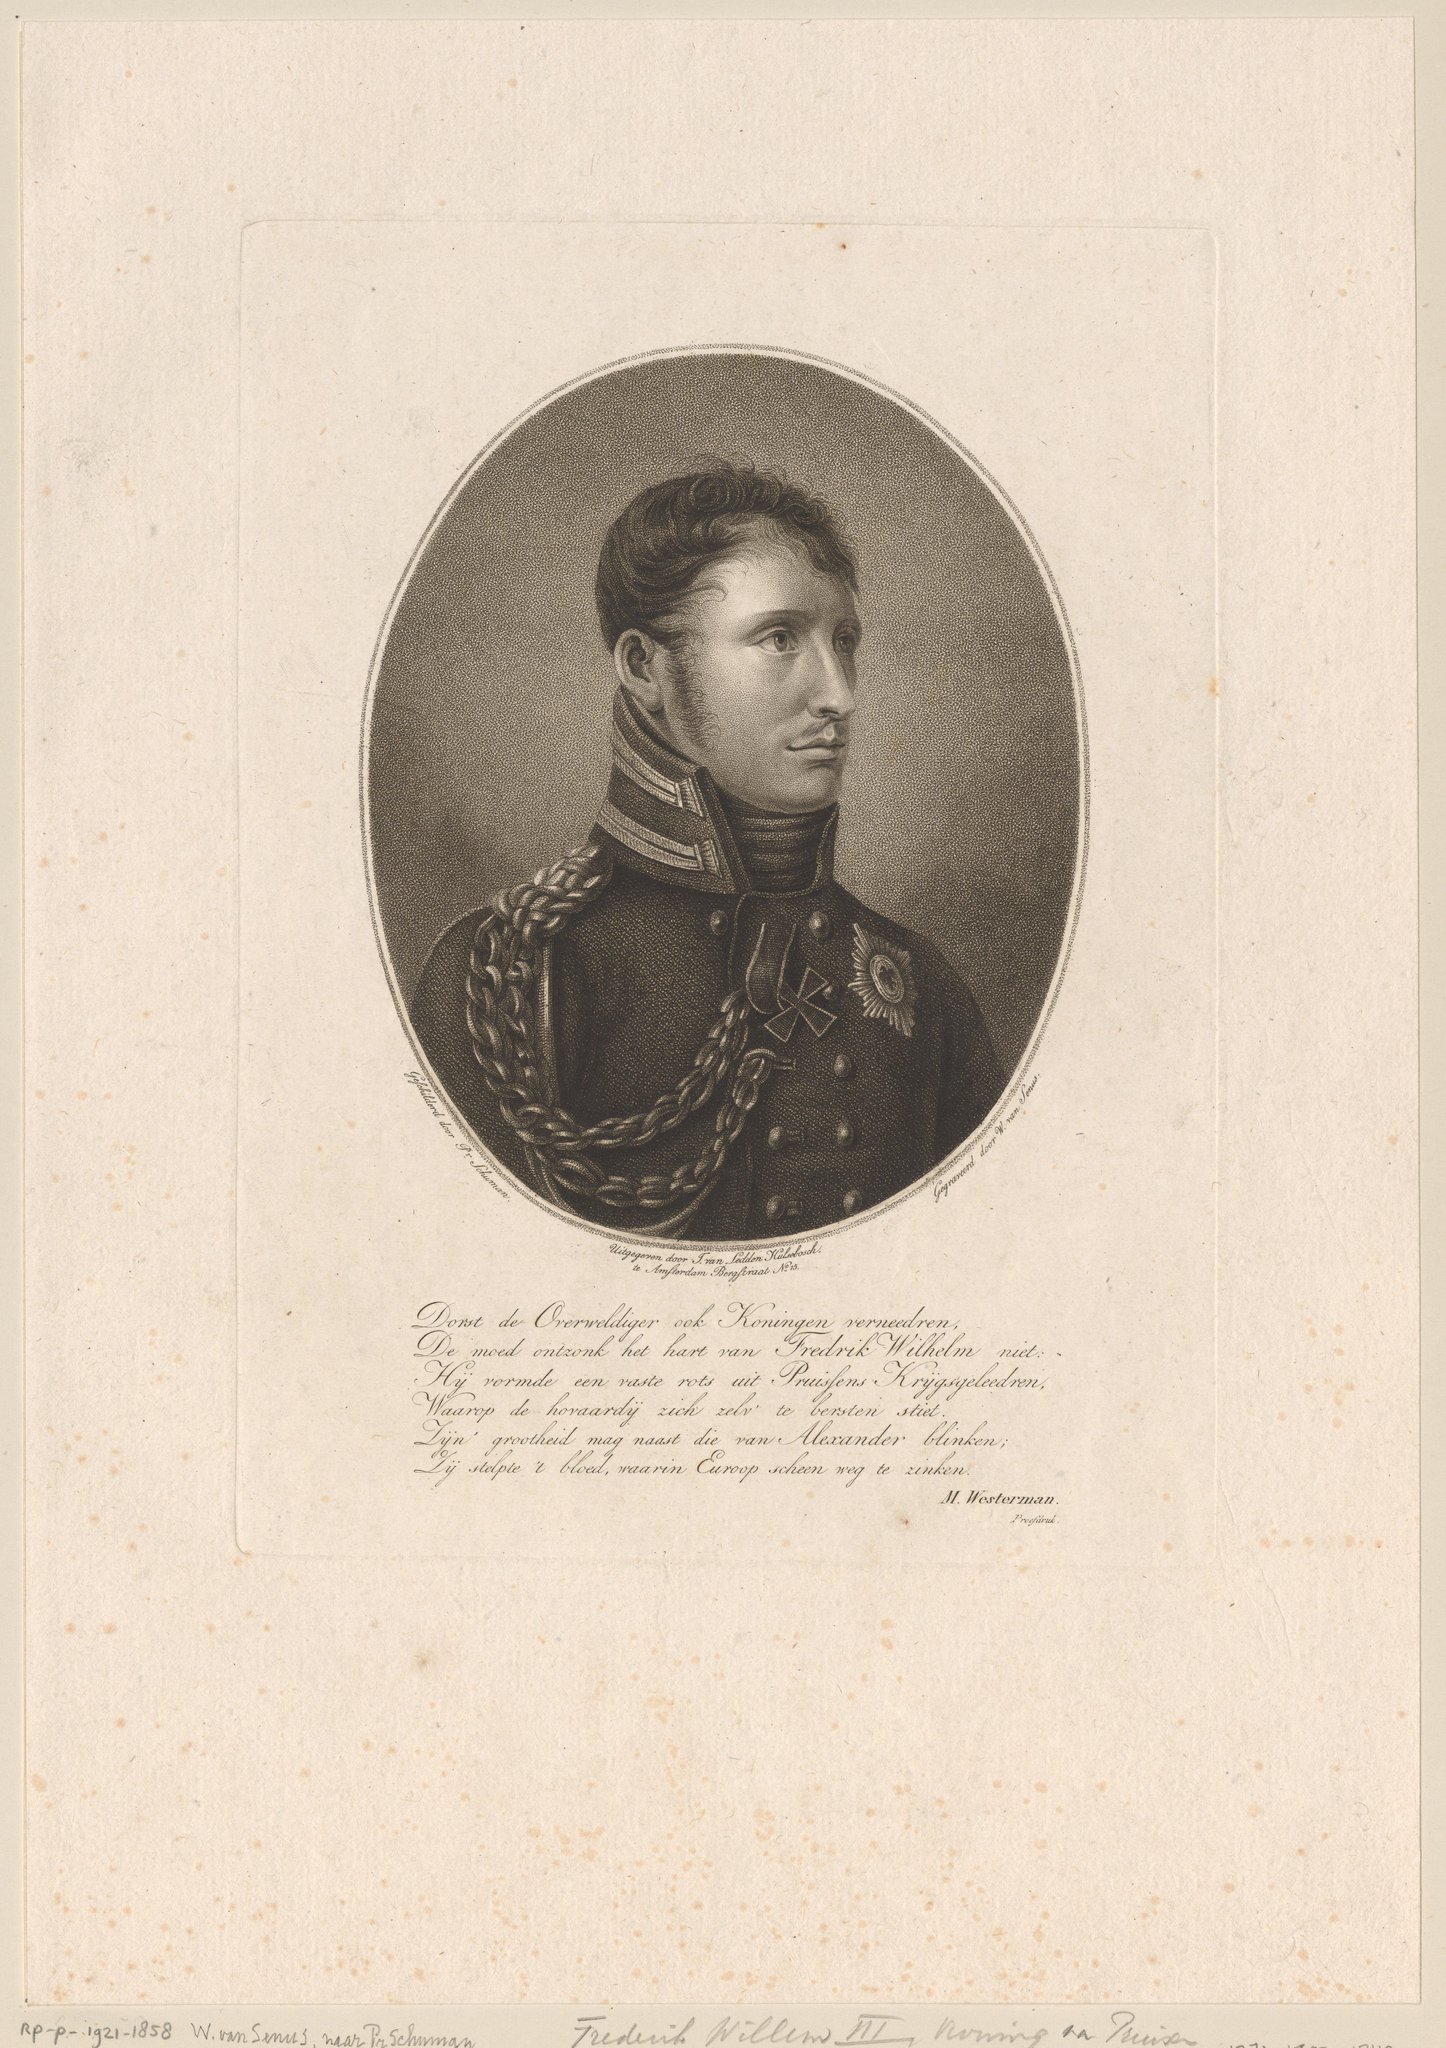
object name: print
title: Portret van Frederik Willem III van Pruisen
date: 1802-1819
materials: paper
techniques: engraving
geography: amsterdam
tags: berlin, frederik willem iii koning van pruisen, historical persons, king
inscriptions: collector's mark: Lugt 2233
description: Met zesregelig vers in het Nederlands onder het portret.